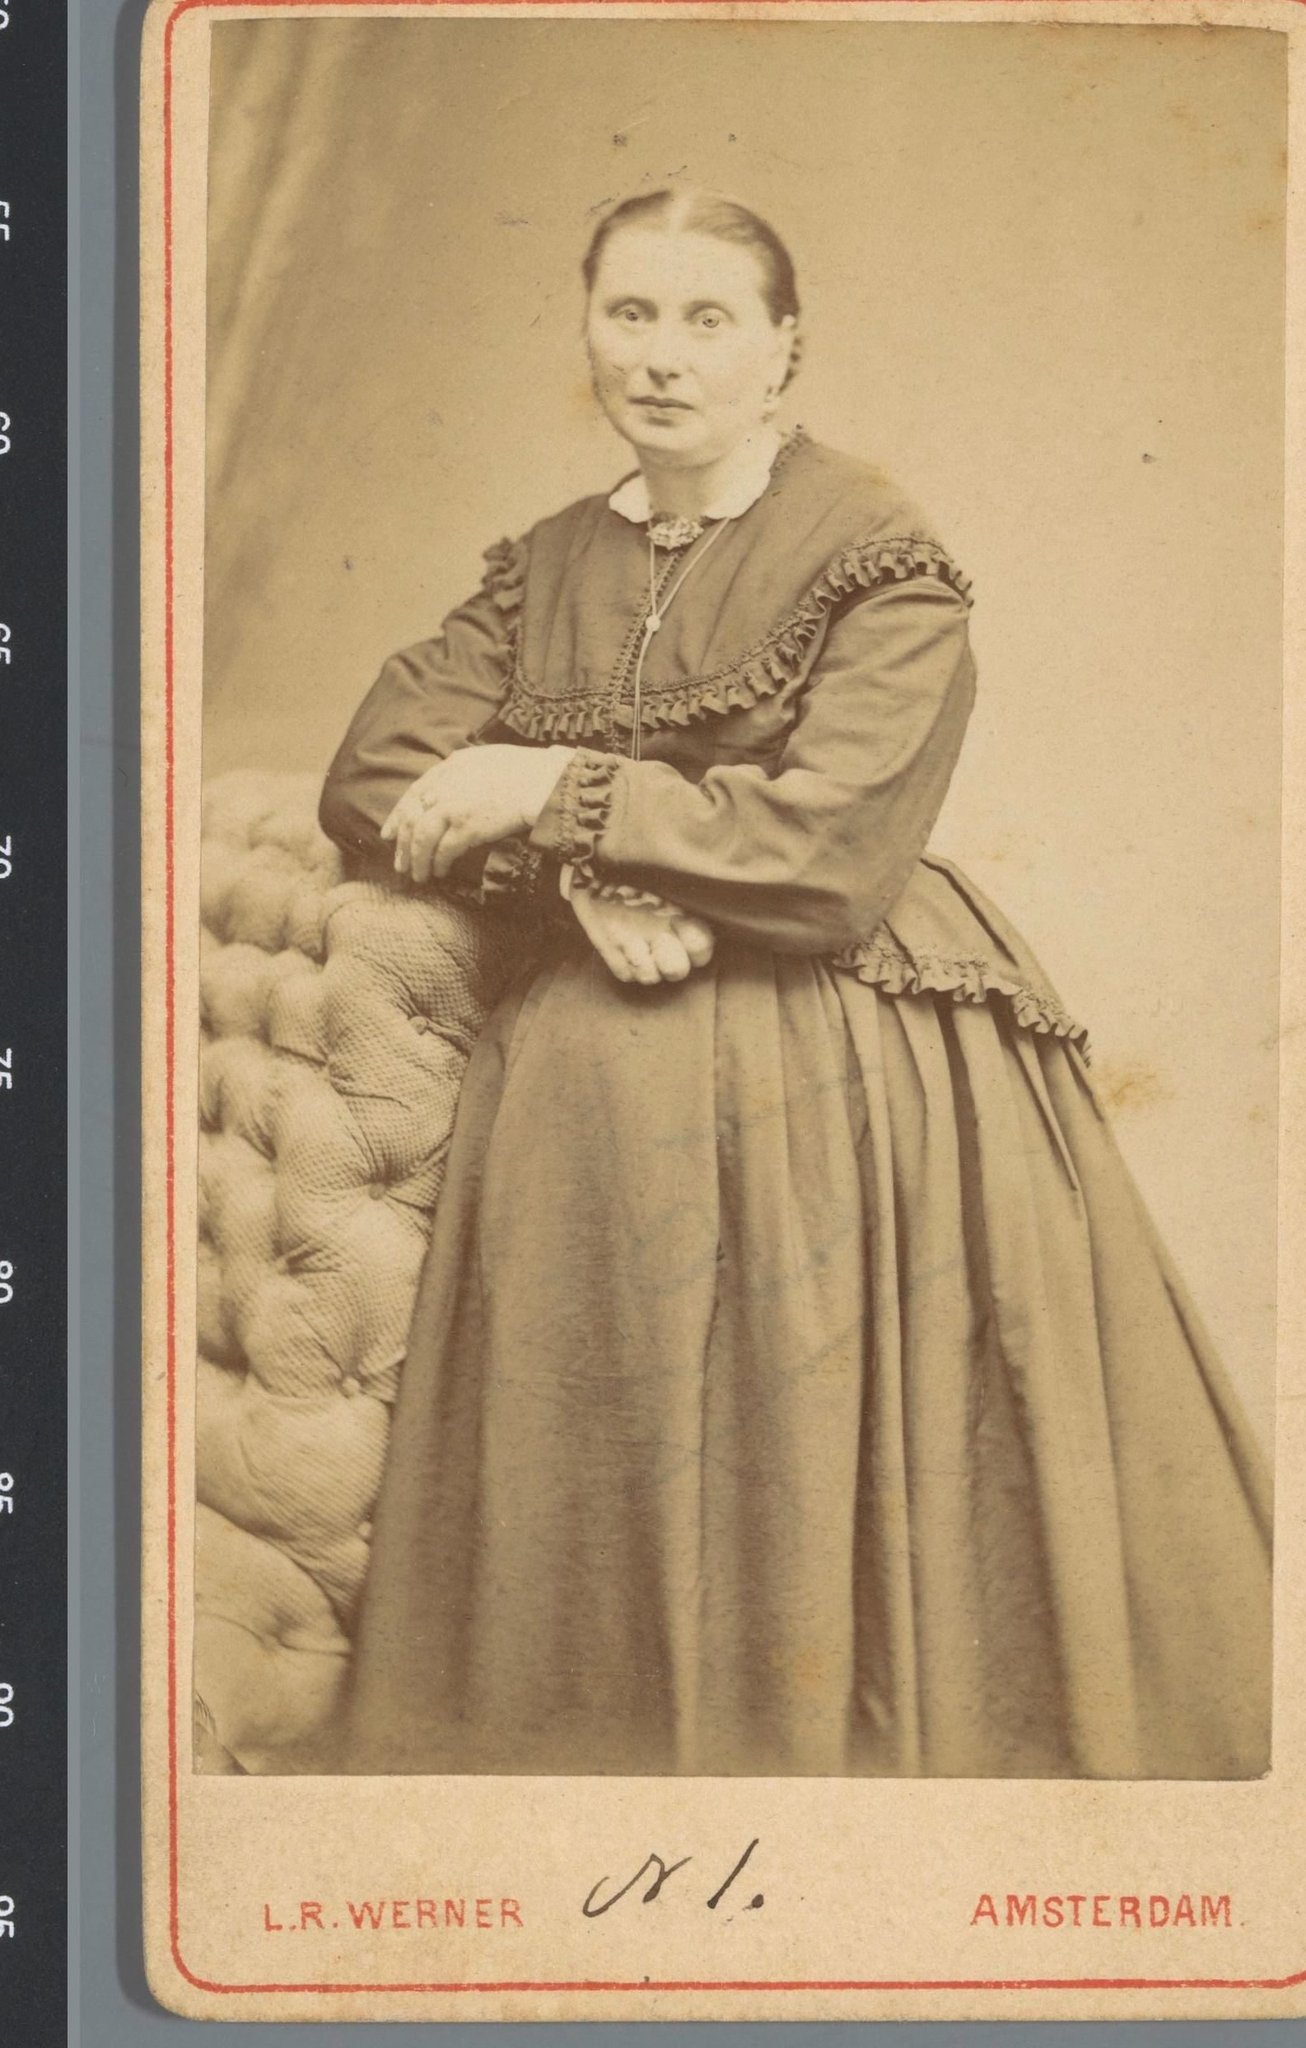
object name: carte de visite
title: Portret van een onbekende vrouw bij een stoel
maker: louis robert werner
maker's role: fotograaf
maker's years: 1834-1896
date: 1871-1877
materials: cardboard, paper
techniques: albumen print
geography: amsterdam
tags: adult woman, anonymous historical person portrayed, amsterdam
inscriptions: inscription: ‘L.R. Werner/ voorheen/ P. Carstensen/ Nieuwendyk H.201/ Amsterdam./ Voor nabestellingen blijft de Plaat bewaard.’, inscription: ‘N 1.’, inscription: ‘L.R. Werner Amsterdam.’, number: ‘137’